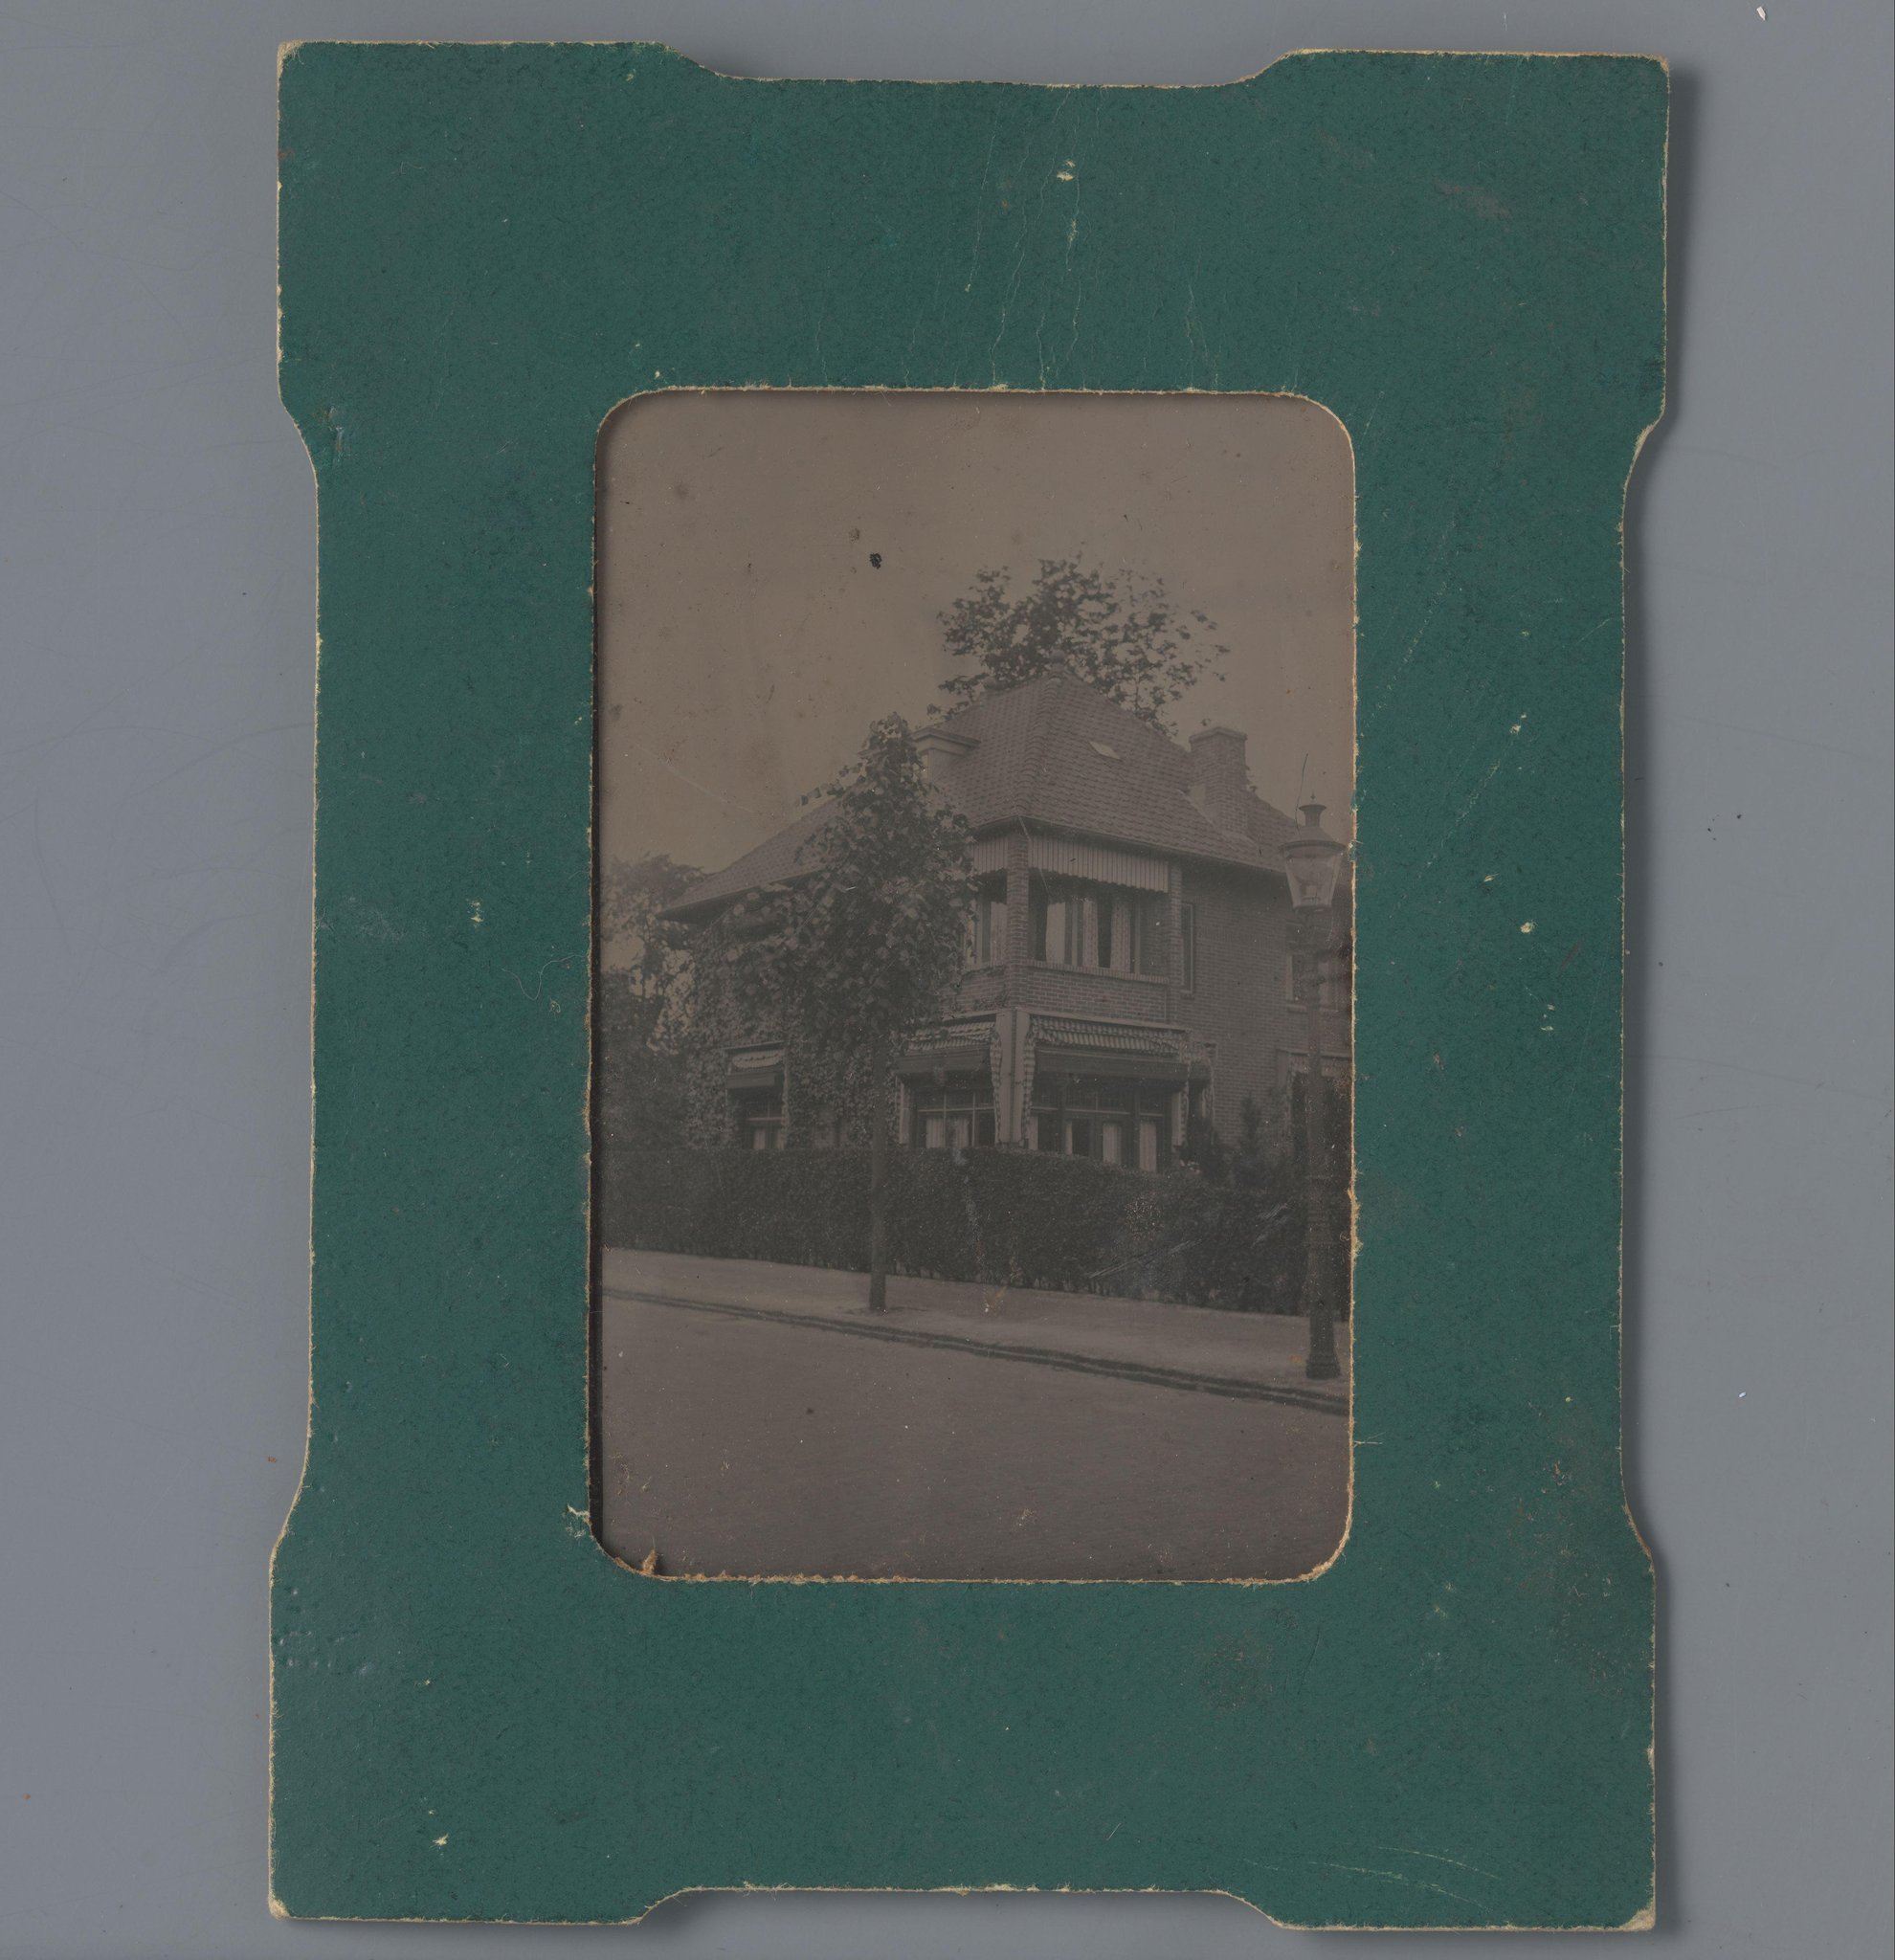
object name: frame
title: Gezicht op een vrijstaand huis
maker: Anonymous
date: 1855-1900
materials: cardboard, iron, paper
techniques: ferrotyping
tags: urban housing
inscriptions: inscription: ‘D.R.G.M.’